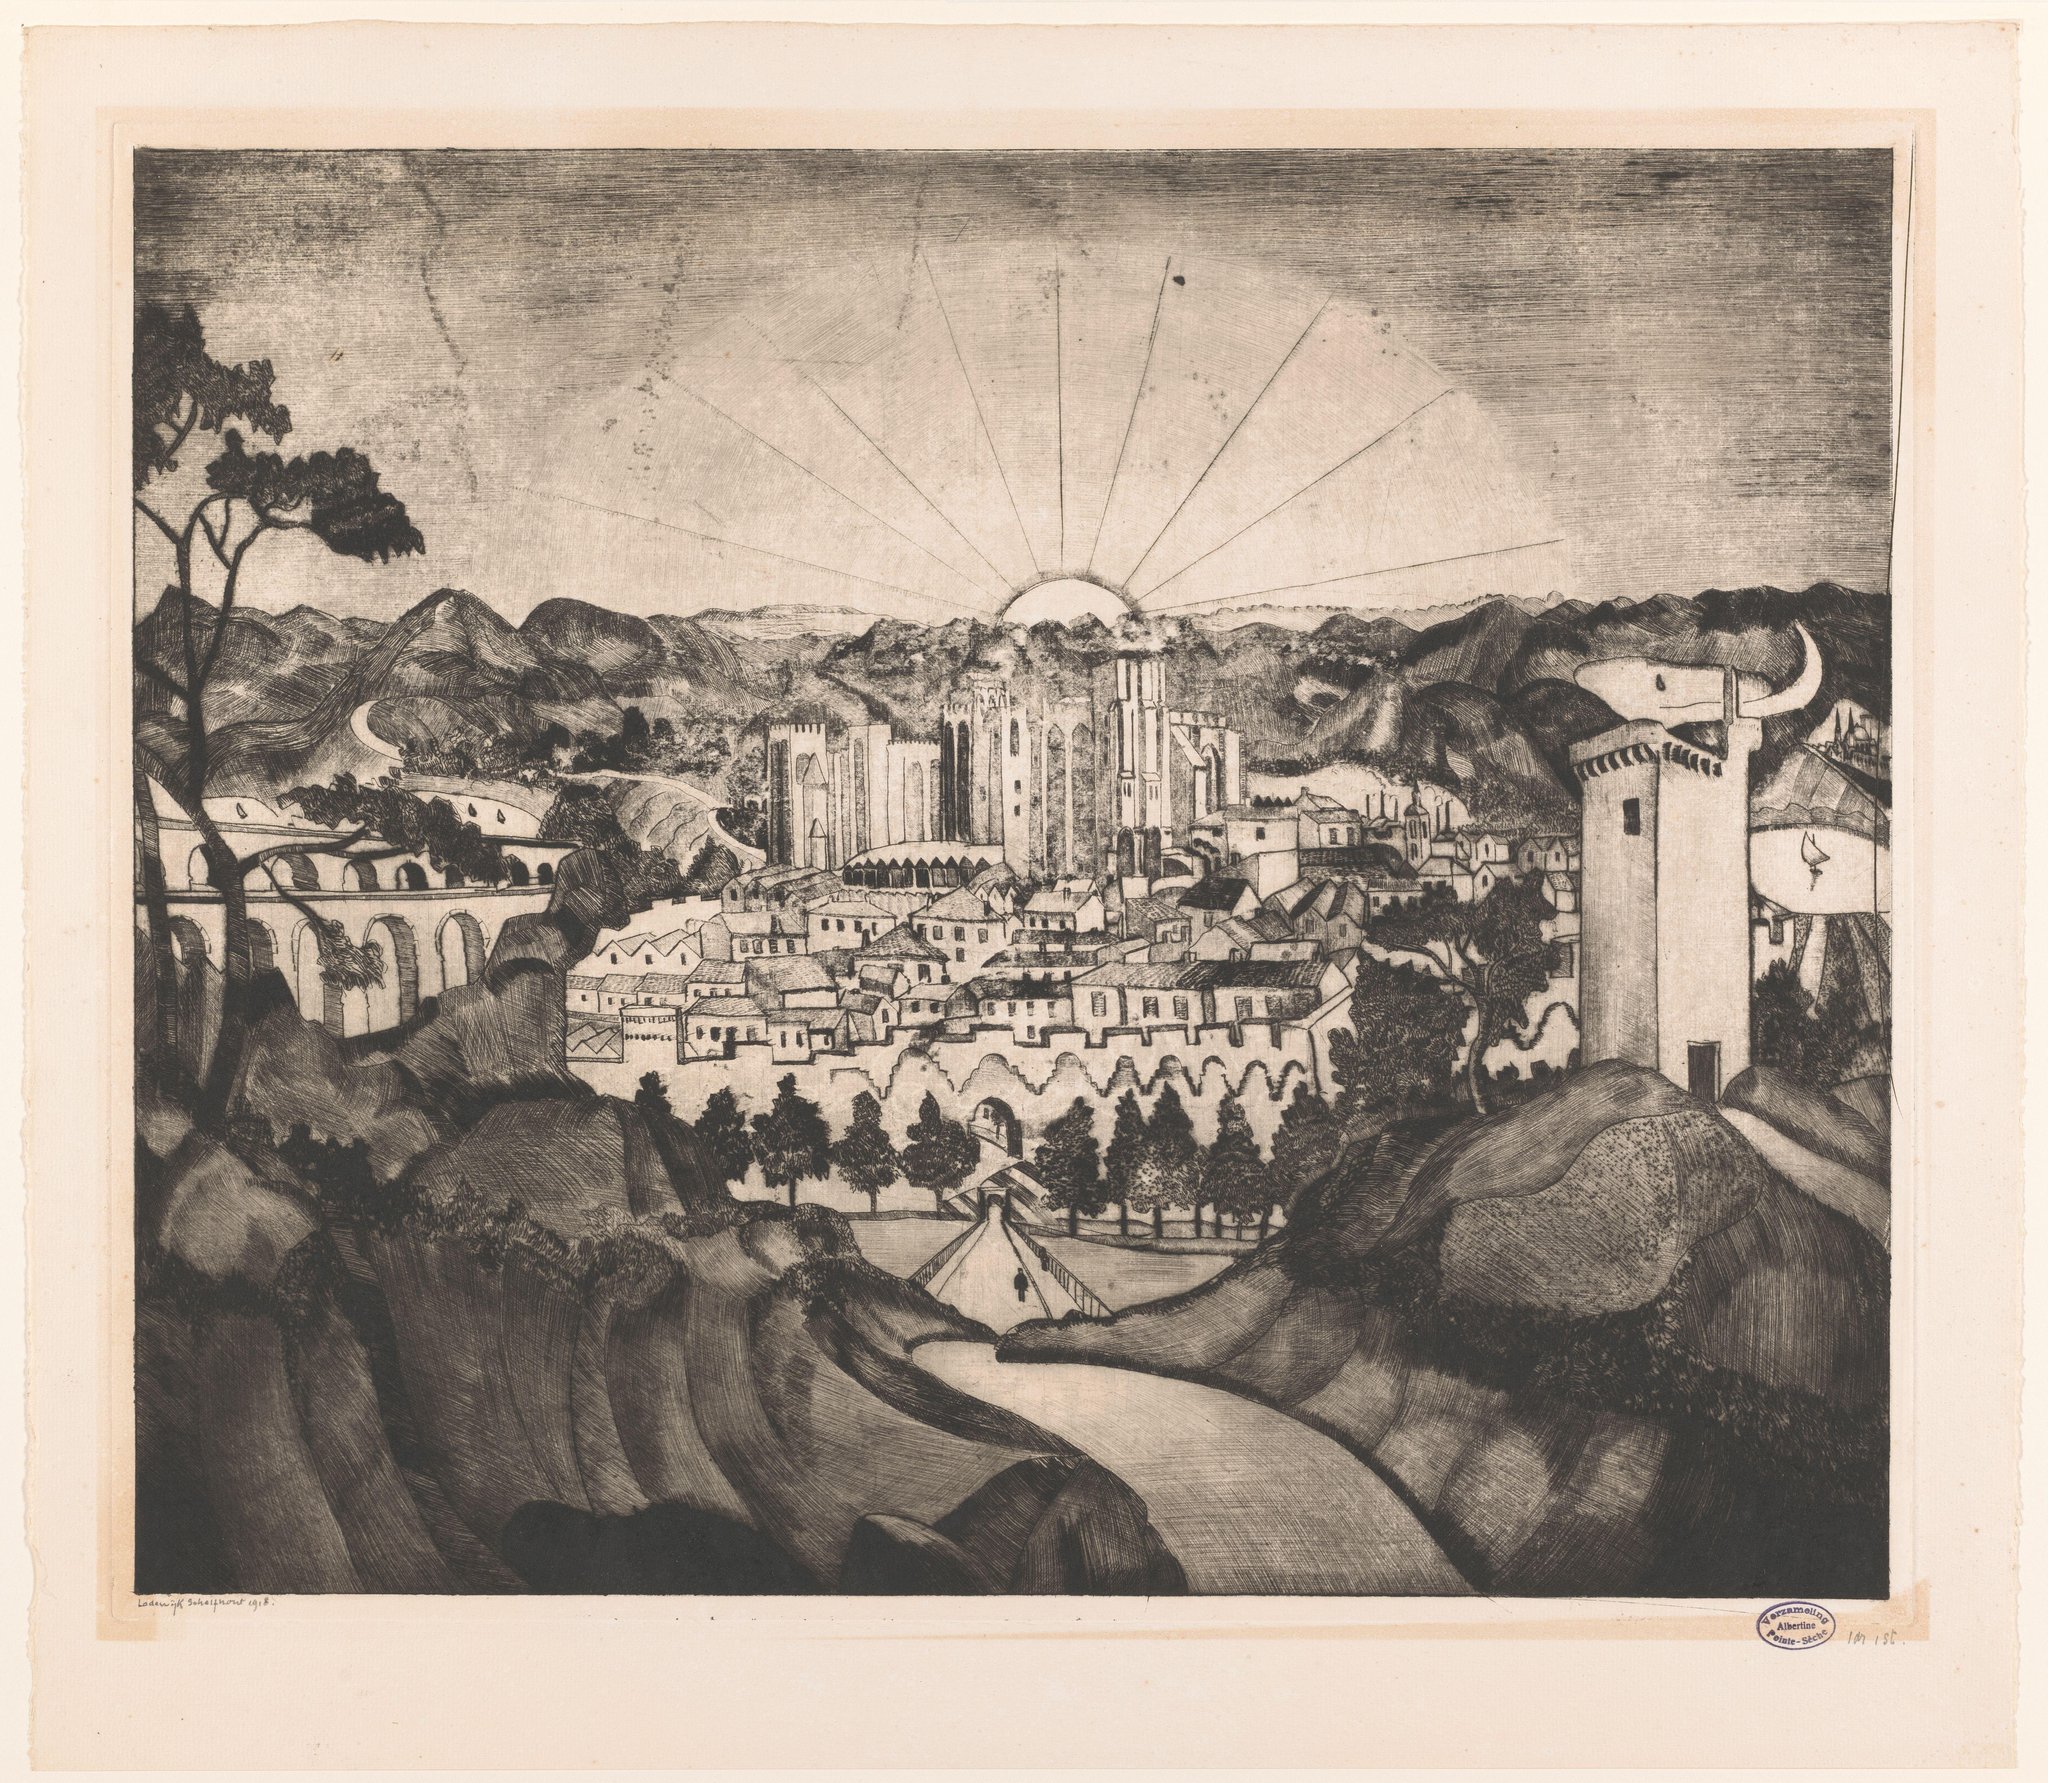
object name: print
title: Avignon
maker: lodewijk schelfhout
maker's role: draughtsman, print maker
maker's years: 1881-1943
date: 1918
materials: paper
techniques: drypoint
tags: city-view, and landscape with man-made constructions, sun as celestial body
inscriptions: collector's mark: Lugt 5i, collector's mark: Lugt 2760, collector's mark: Lugt 2228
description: De opgaande of ondergaande zon boven de stad Avignon in het zuiden van Frankrijk.